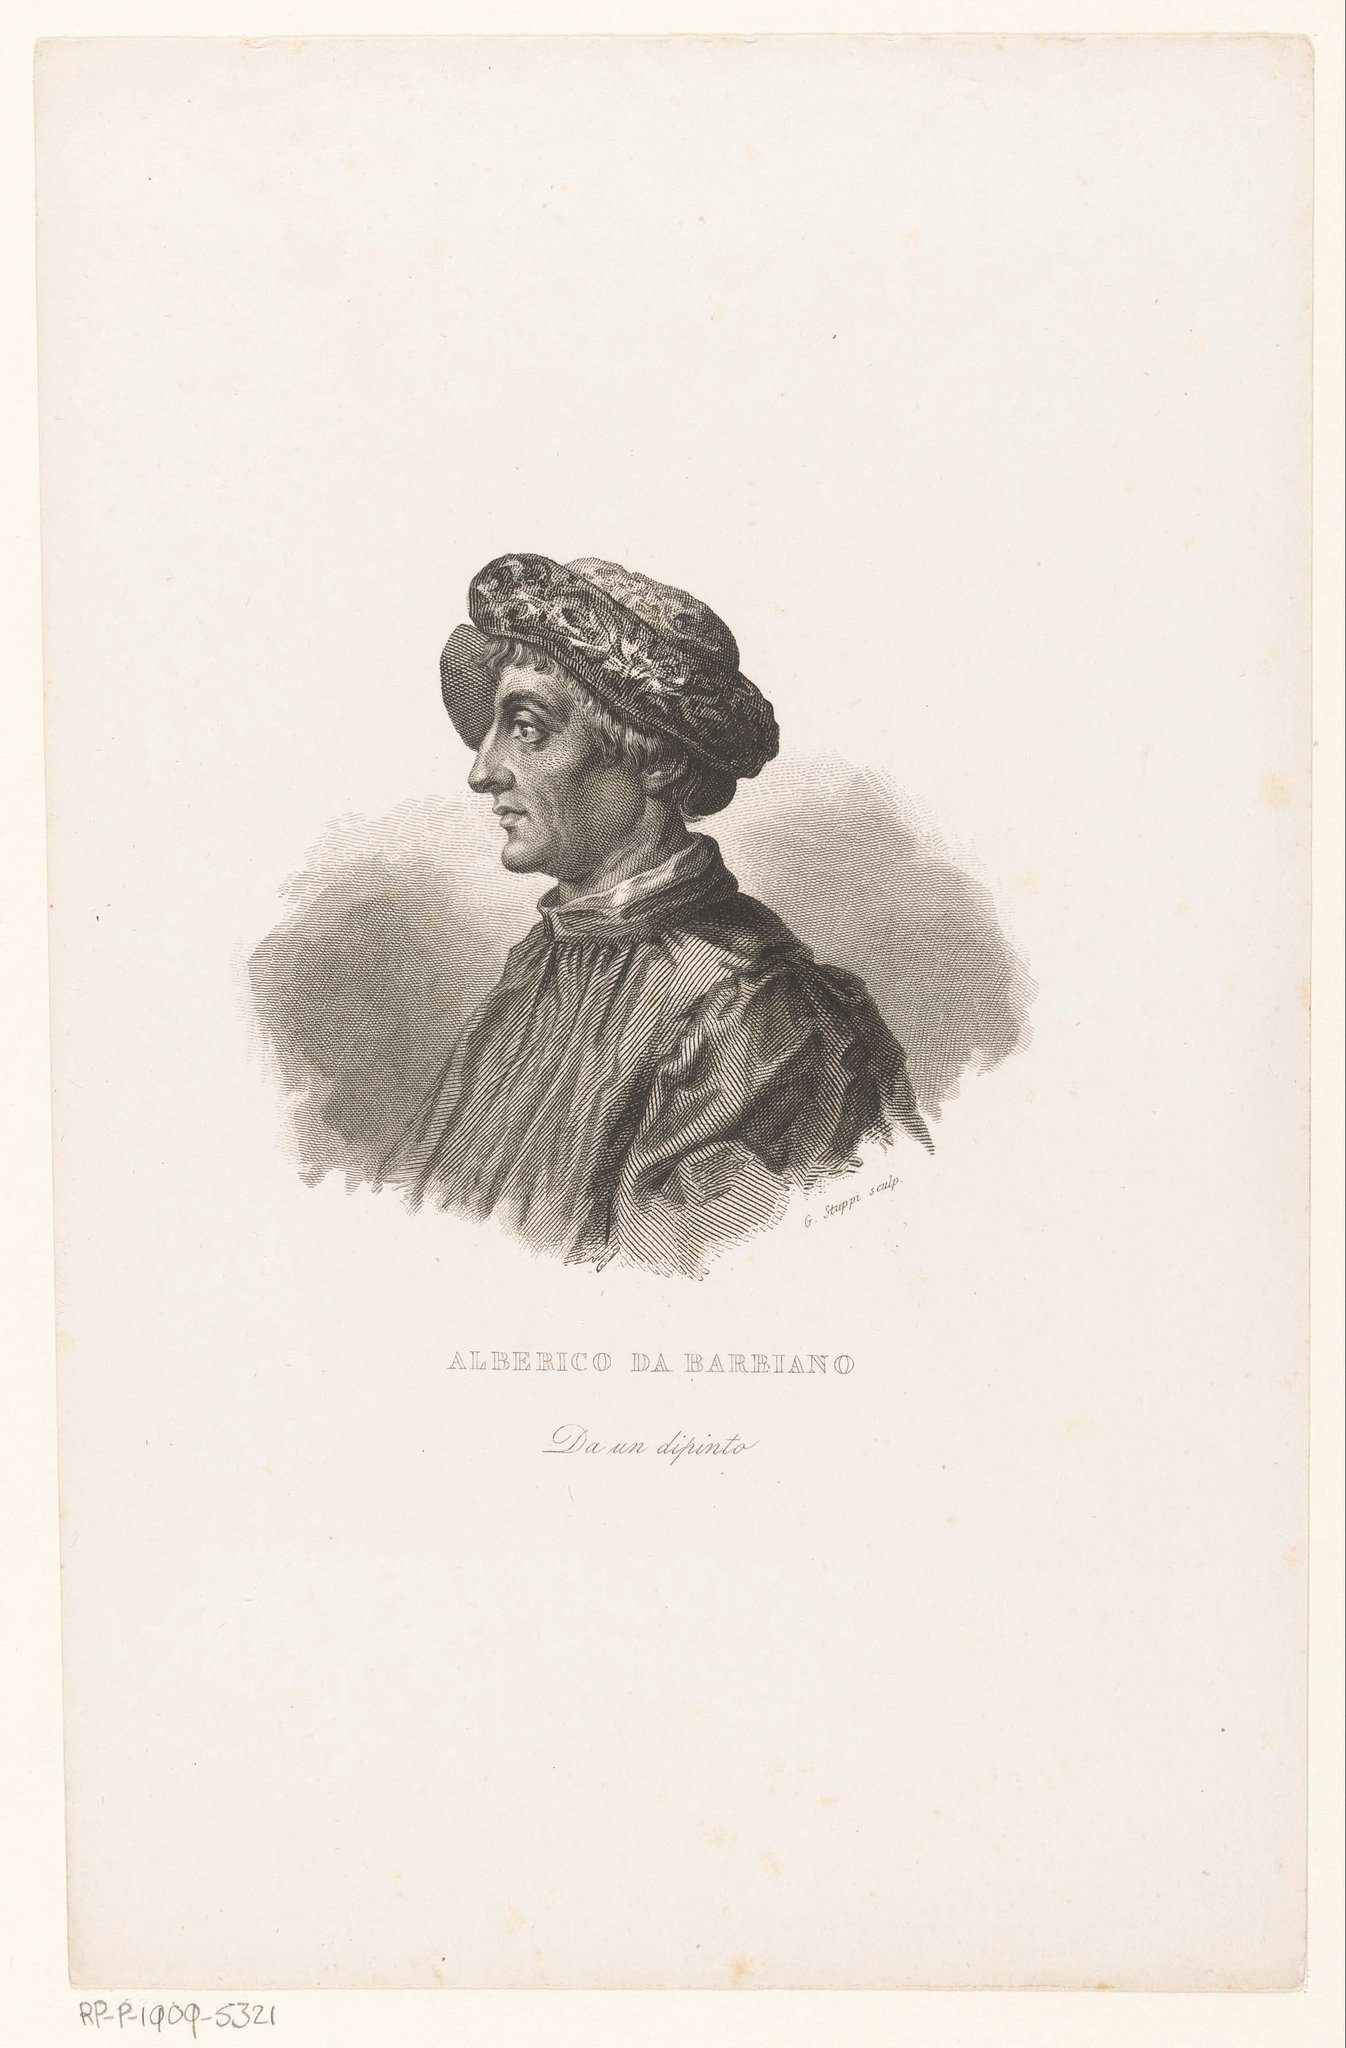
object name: print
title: Portret van militair Alberico da Barbiano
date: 1800-1899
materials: paper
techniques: engraving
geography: italy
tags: historical persons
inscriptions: collector's mark: Lugt 2228